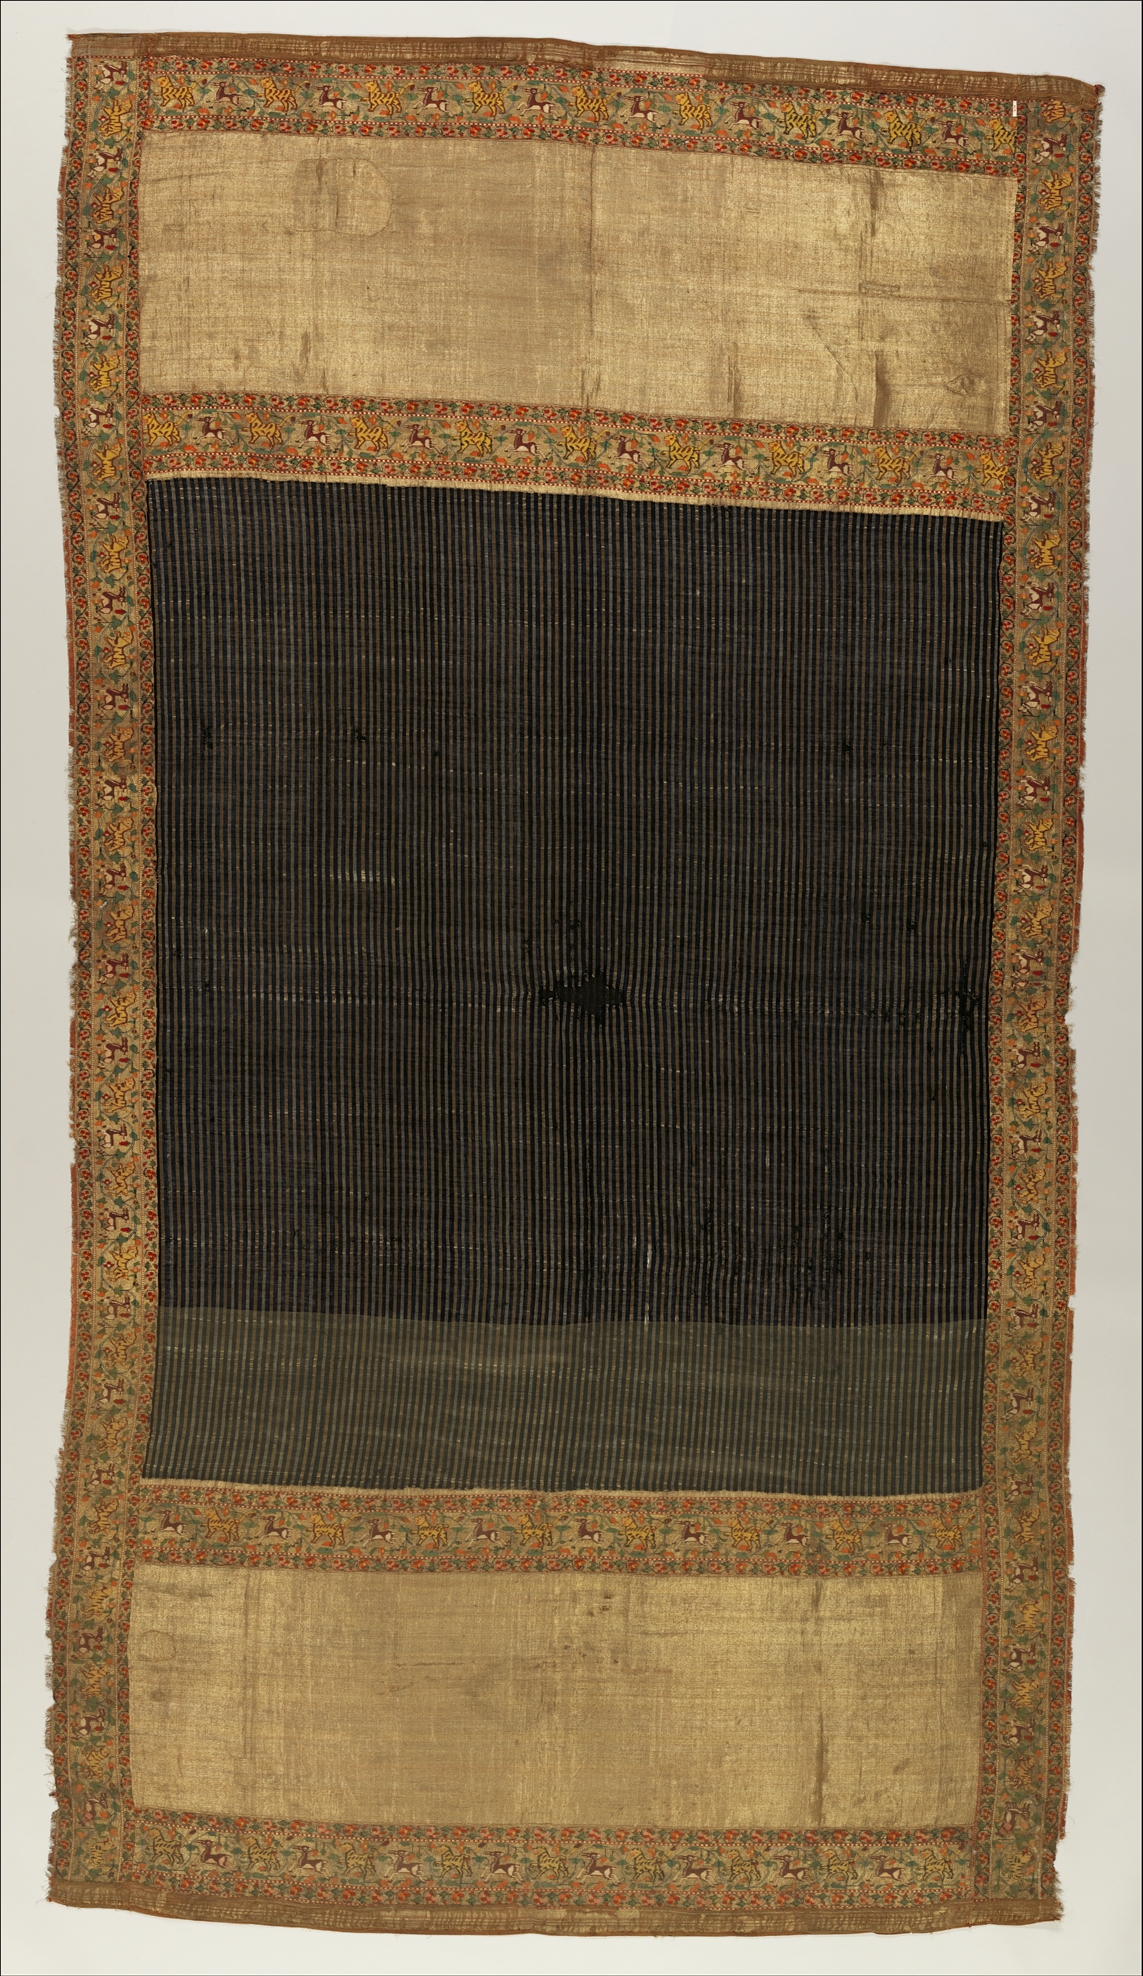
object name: chadar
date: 1700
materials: cotton, metal thread, silk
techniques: tapestry, weave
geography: india